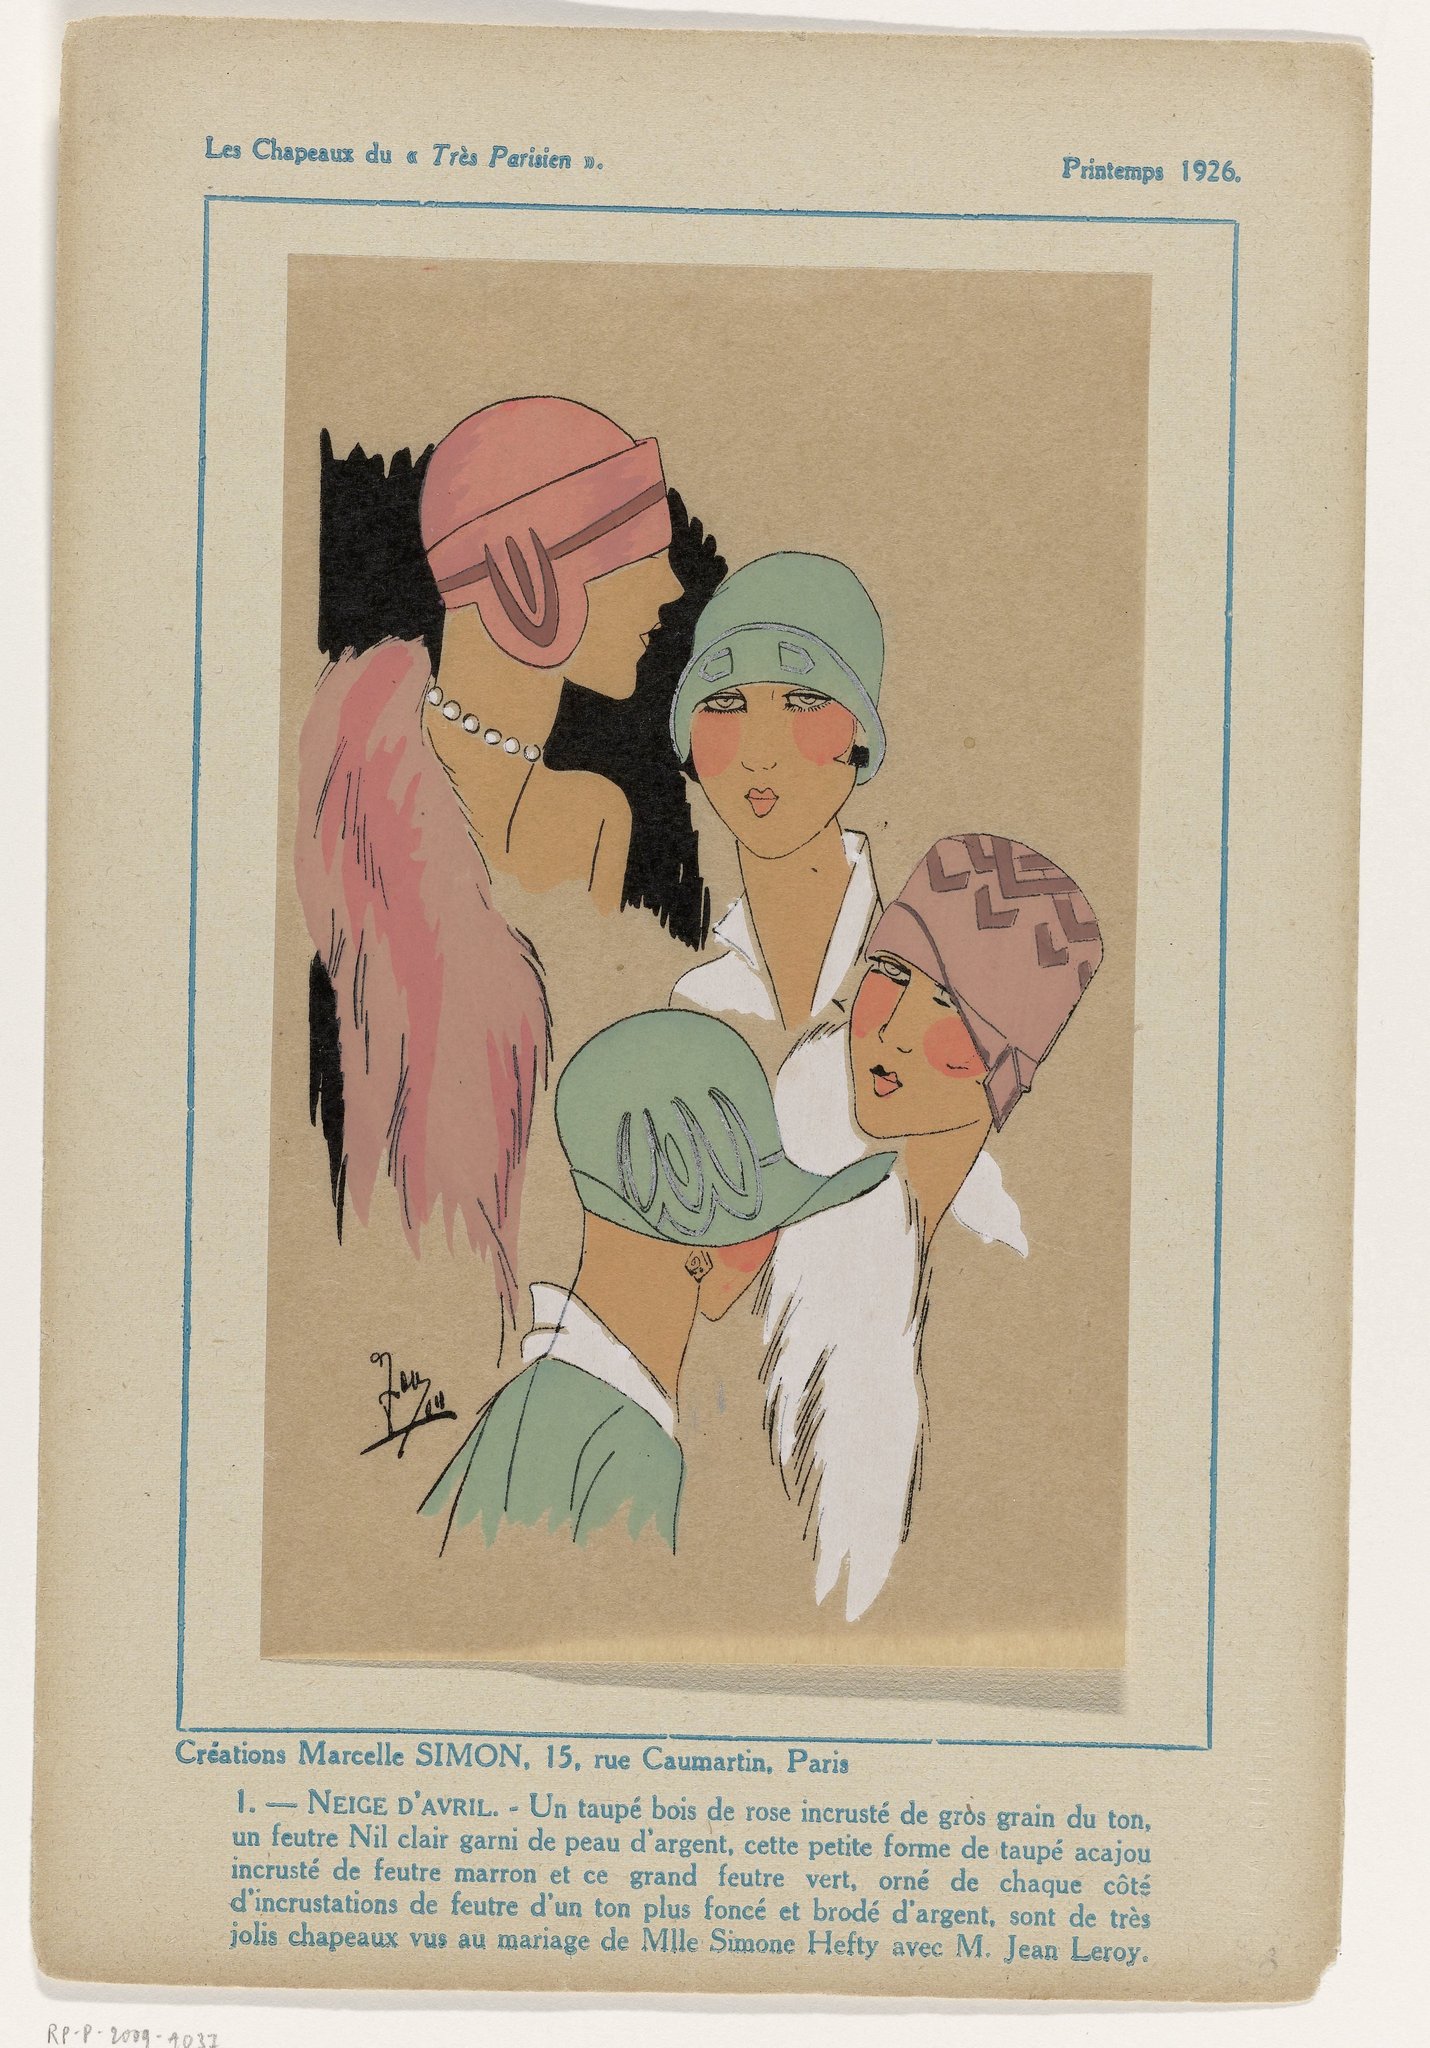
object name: fashion print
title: Les Chapeaux du "Très Parisien", Printemps 1926 : Créations Marcelle Simon (...)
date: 1926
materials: paper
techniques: hand coloring, letterpress printing, lithography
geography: paris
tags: embroidery (ornamentation) (+ women's clothes), fashion plates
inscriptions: title: ‘Les Chapeaux du "Très Parisien" / Printemps 1926.’, caption: ‘Créations Marcelle SIMON, 15, rue Caumartin, Paris / 1. - NEIGE D'AVRIL. - Un taupé bois de rose incrusté de gros grain du ton, un feutre NIl clair garni de peau d'argent, cette petite forme de taupé acajou incrusté de feutre marron et ce grand feutre vert, orné de chaque côté d'incrustations de feutre d'un ton plus foncé et brodé d'argent, sont de très jolis chapeaux vus au mariage de Mlle Simone Hefty avec M. Jean Leroy.’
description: Vier vrouwenhoofden met verschillende pothoeden ontworpen door Marcelle Simon. Cloche (pothoed) van groen vilt met zilverkleurig borduursel. Volgens het onderschrift zijn deze cloches (pothoeden) gezien op de bruiloft van Simone Hefty en Jean Leroy. Prent uit het modetijdschrift Très Parisien (1920-1936).